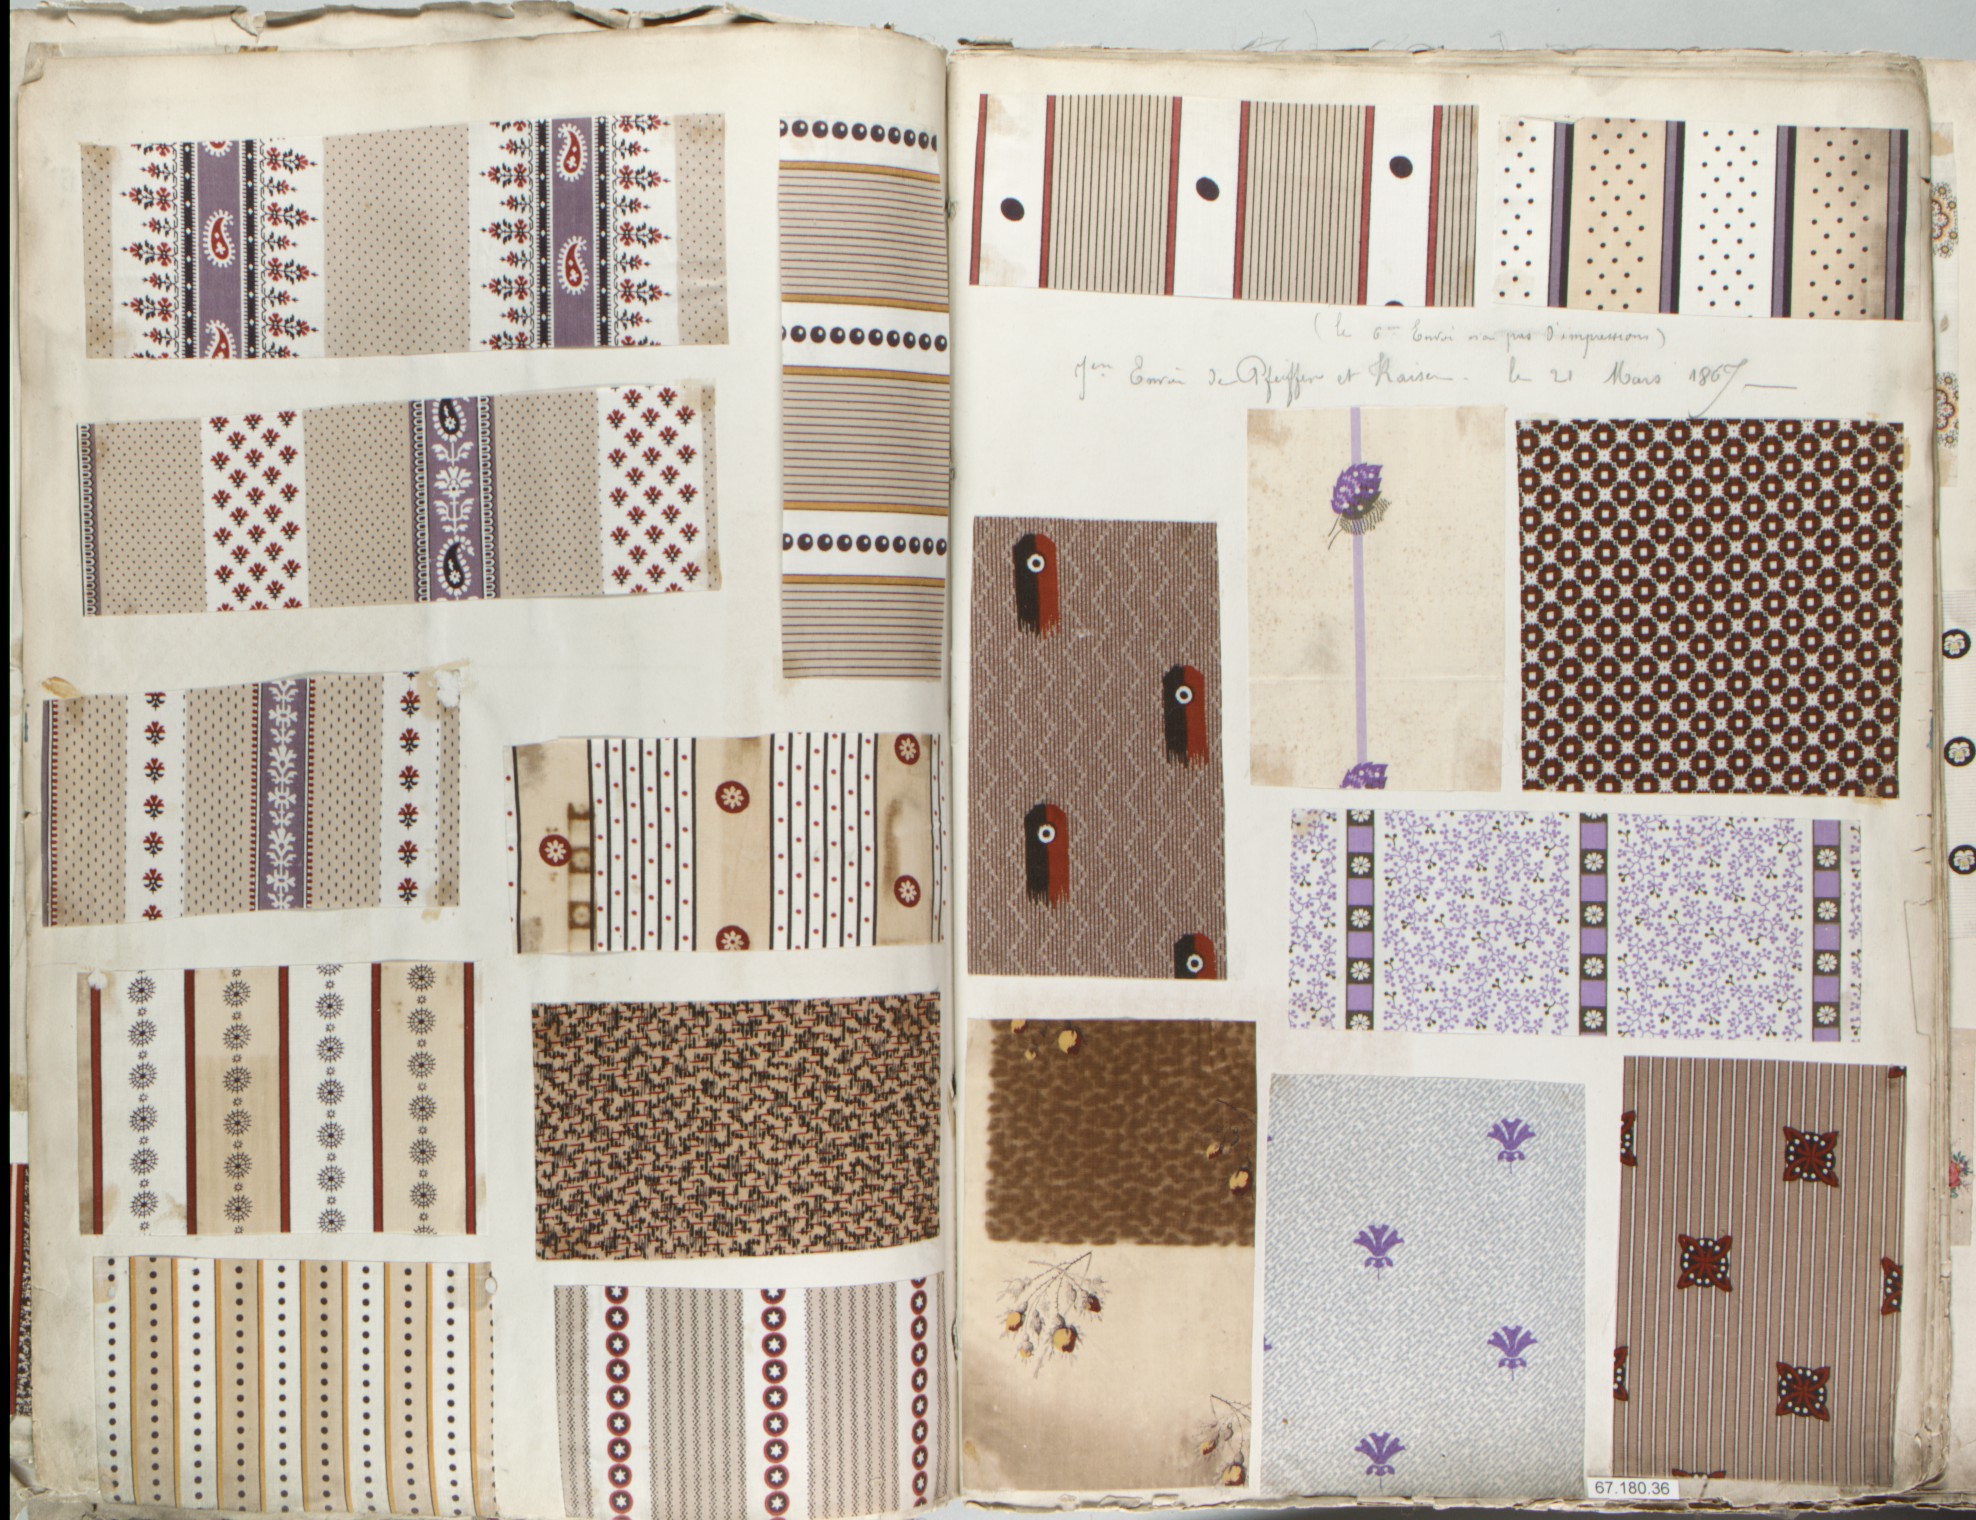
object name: sample book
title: Textile Sample Book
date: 1850-1900